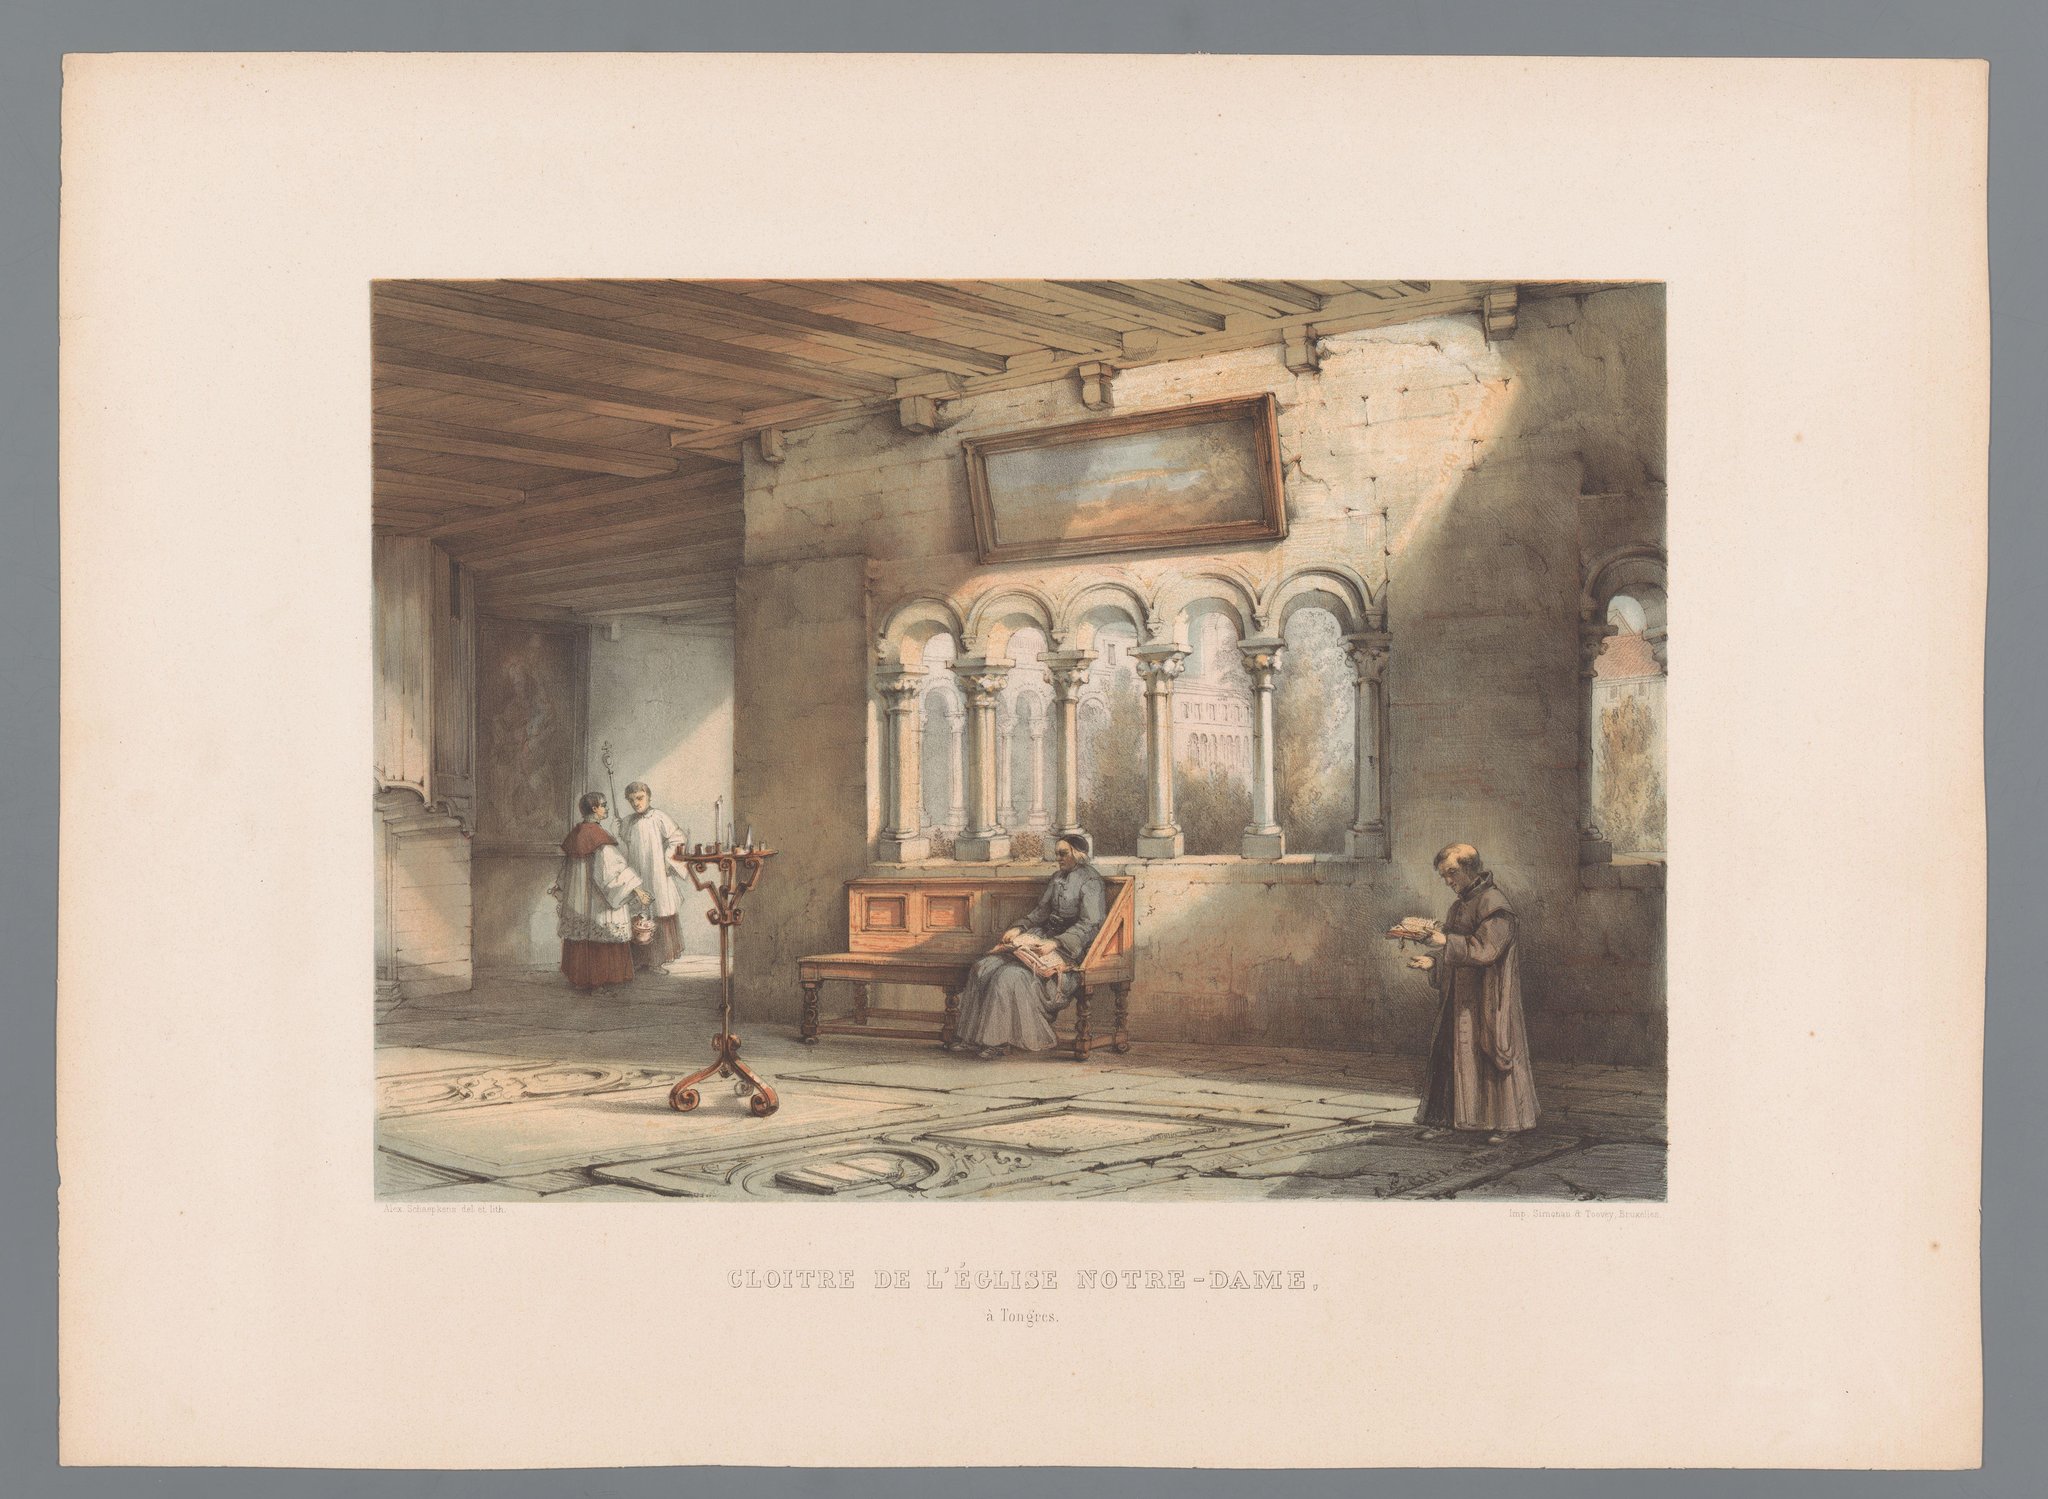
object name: print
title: Cloitre de l'Église Notre-Dame, à Tongres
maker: alexander schaepkens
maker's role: draughtsman, print maker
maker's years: 1815-1899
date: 1830-1899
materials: paper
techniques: lithograph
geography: brussels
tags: parts of church interior: ambulatory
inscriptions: collector's mark: Lugt 2228